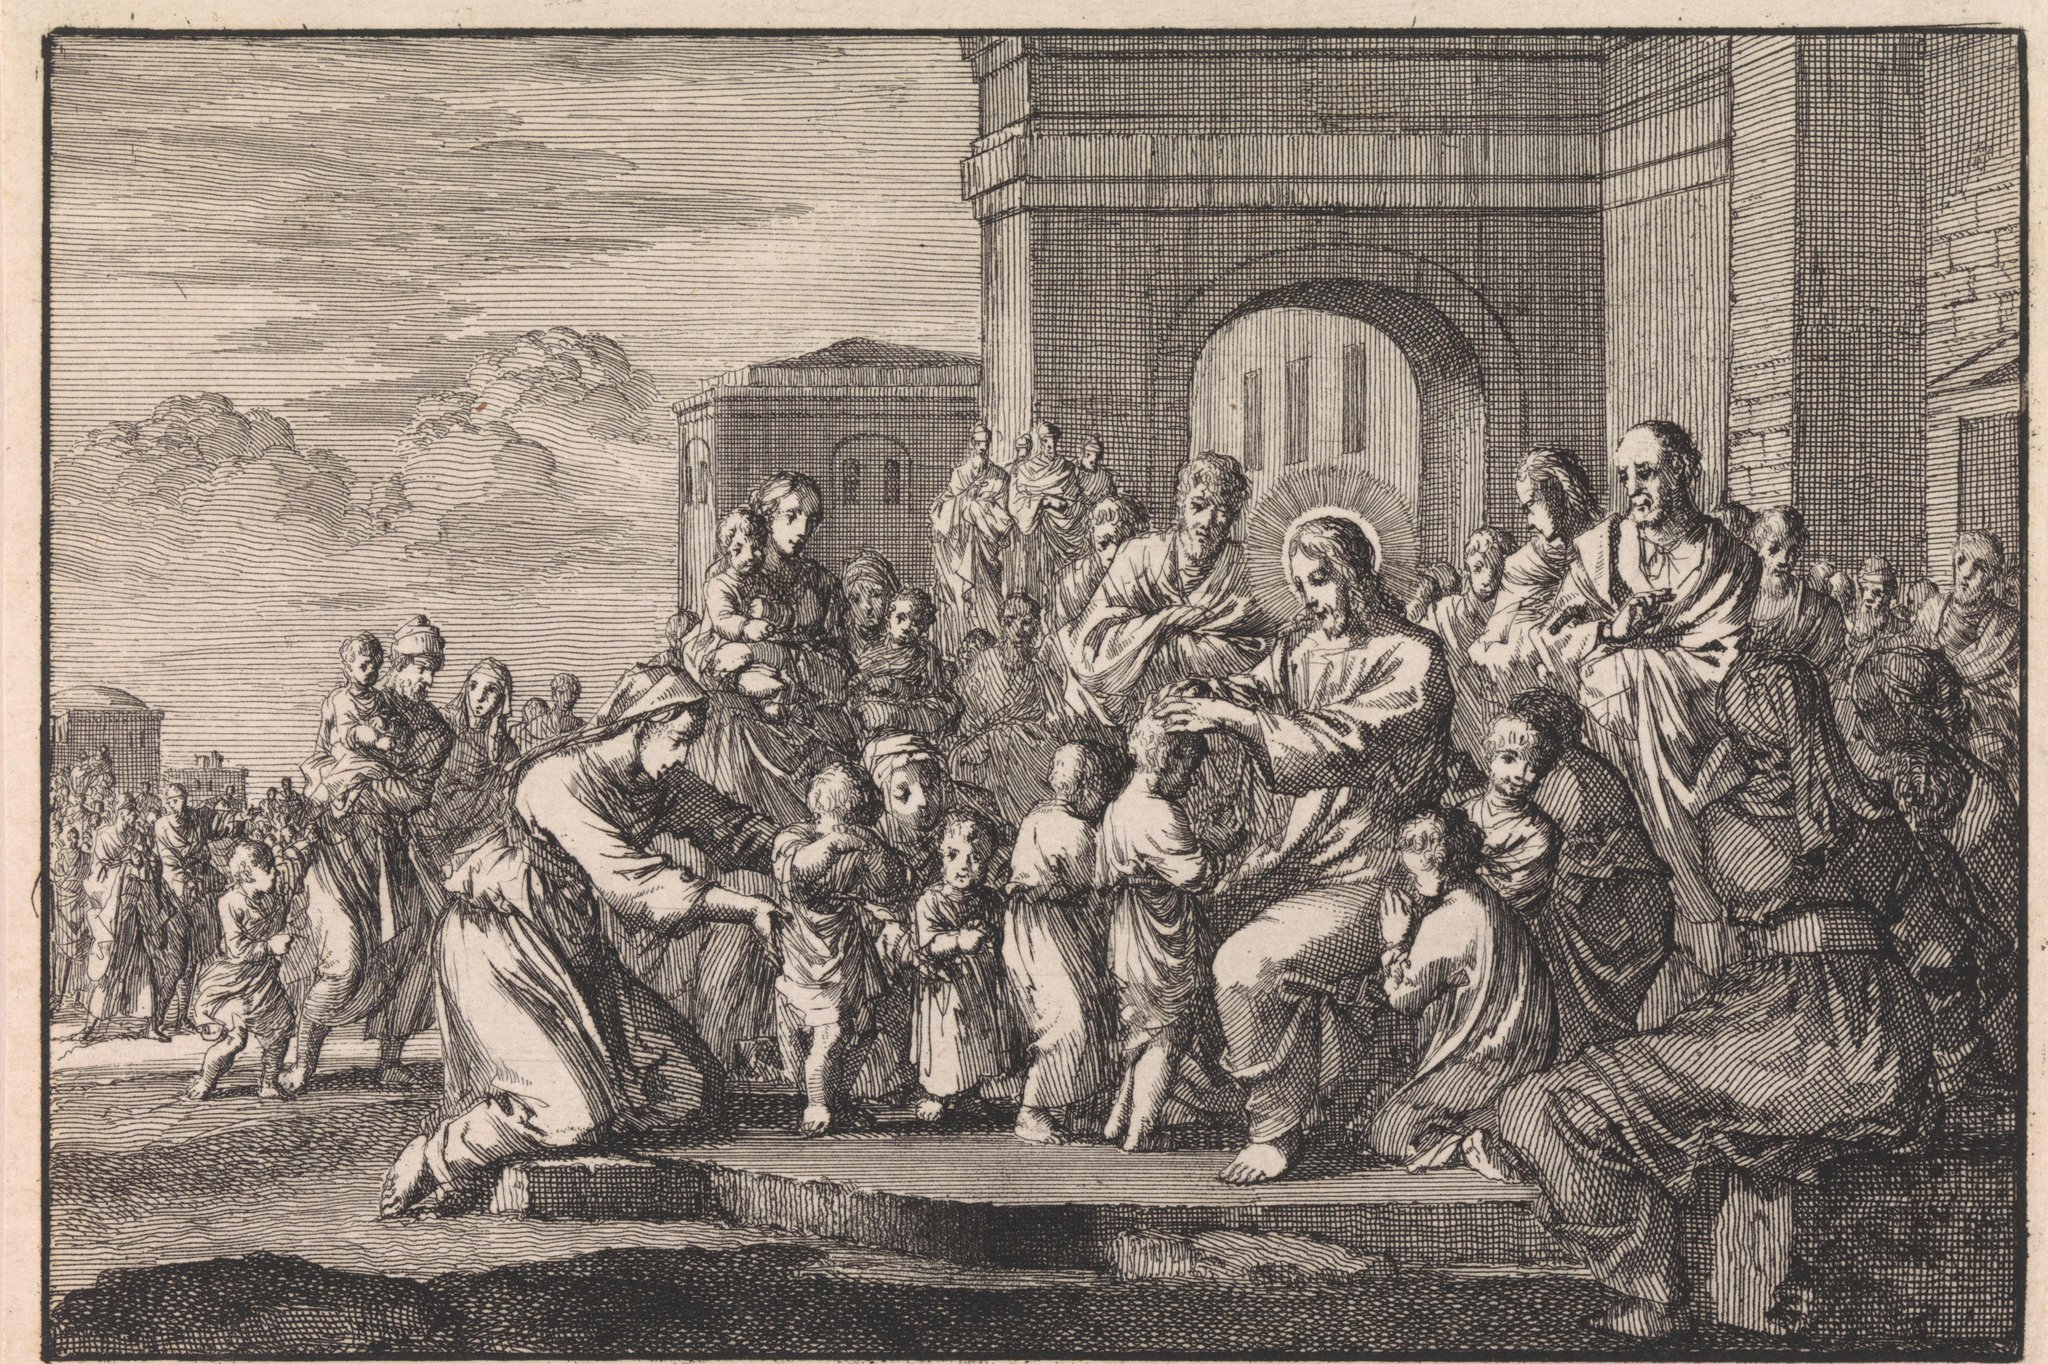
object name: print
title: Christus zegent de kinderen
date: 1703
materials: paper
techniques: etching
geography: amsterdam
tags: christ blessing children brought by their mothers, usually with some disciples disapprovingly looking on (matthew 19:13-15; mark 10:13-16; luke 18:15-17)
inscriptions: collector's mark: Lugt 2228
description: Proefdruk van een boekillustratie voor David Martin. Historie des Ouden en Nieuwen Testaments. Amsterdam, Pieter Mortier, 1703. Deel II. De boekillustraties voor de Mortierbijbel hebben verschillende staten en kopieën, waarbij de chronologische volgorde moeilijk te achterhalen valt. Als boekillustraties werden ze bovendien herhaaldelijk opnieuw gebruikt voor andere boekwerken.